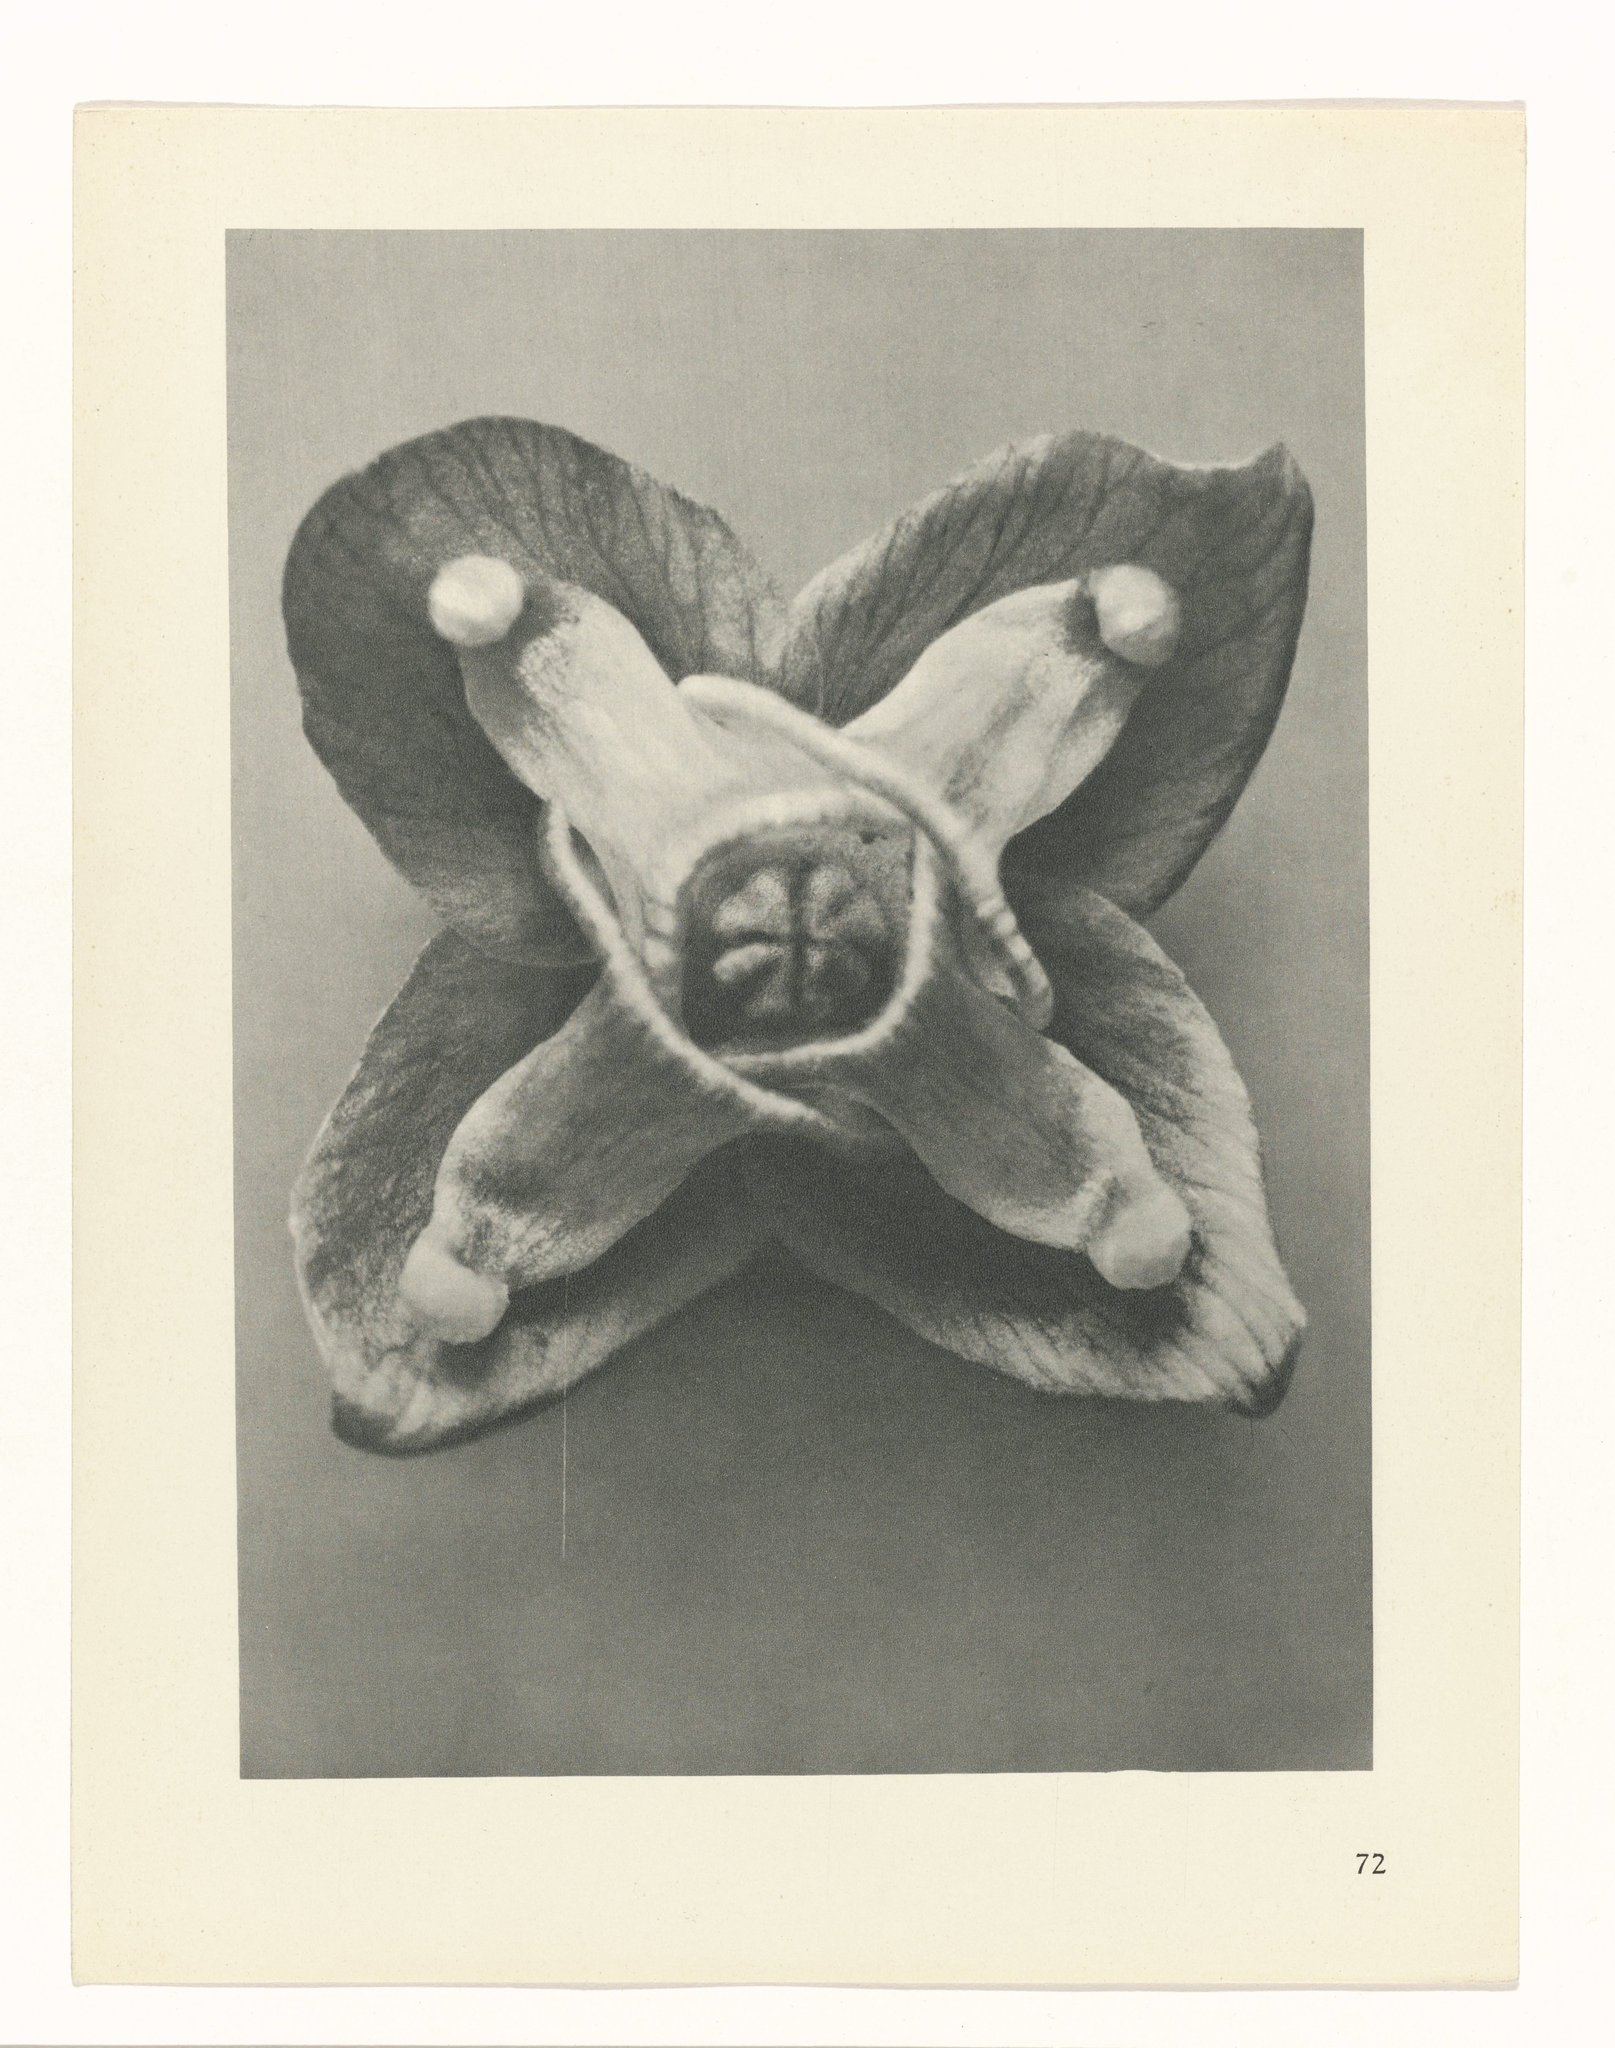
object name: photograph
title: Plantstudie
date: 1928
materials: ink, paper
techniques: rotogravure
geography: berlin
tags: plants (in general)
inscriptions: number: ‘72’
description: facher Vergrößerung. Afkomstig uit losbladige uitgave.